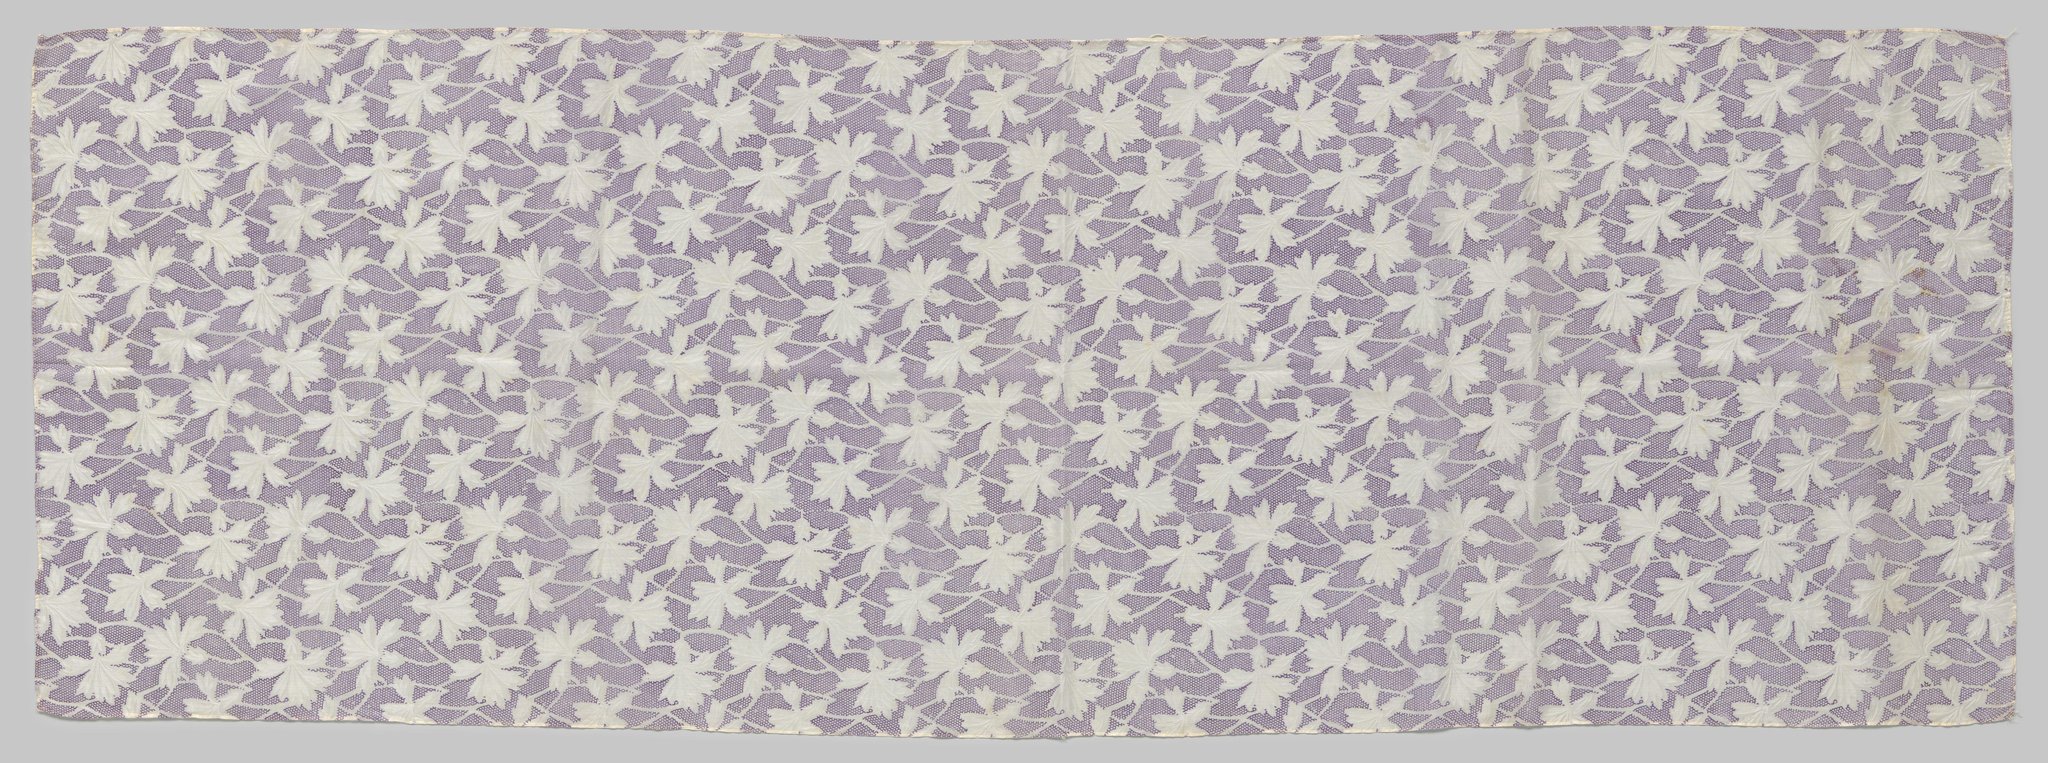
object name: clothing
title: Langwerpige sjaal met een patroon van witte bloemen tegen een achtergrond van gedrukt gaasmotief in paars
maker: Anonymous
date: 1920-1940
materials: ink, silk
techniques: printing, weave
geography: netherlands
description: Langwerpige sjaal van zijde, met een patroon van bijna transprante, witte bloemen met ingeweven bladstructuur, tegen een achtergrond van gedrukt gaasmotief in paars.